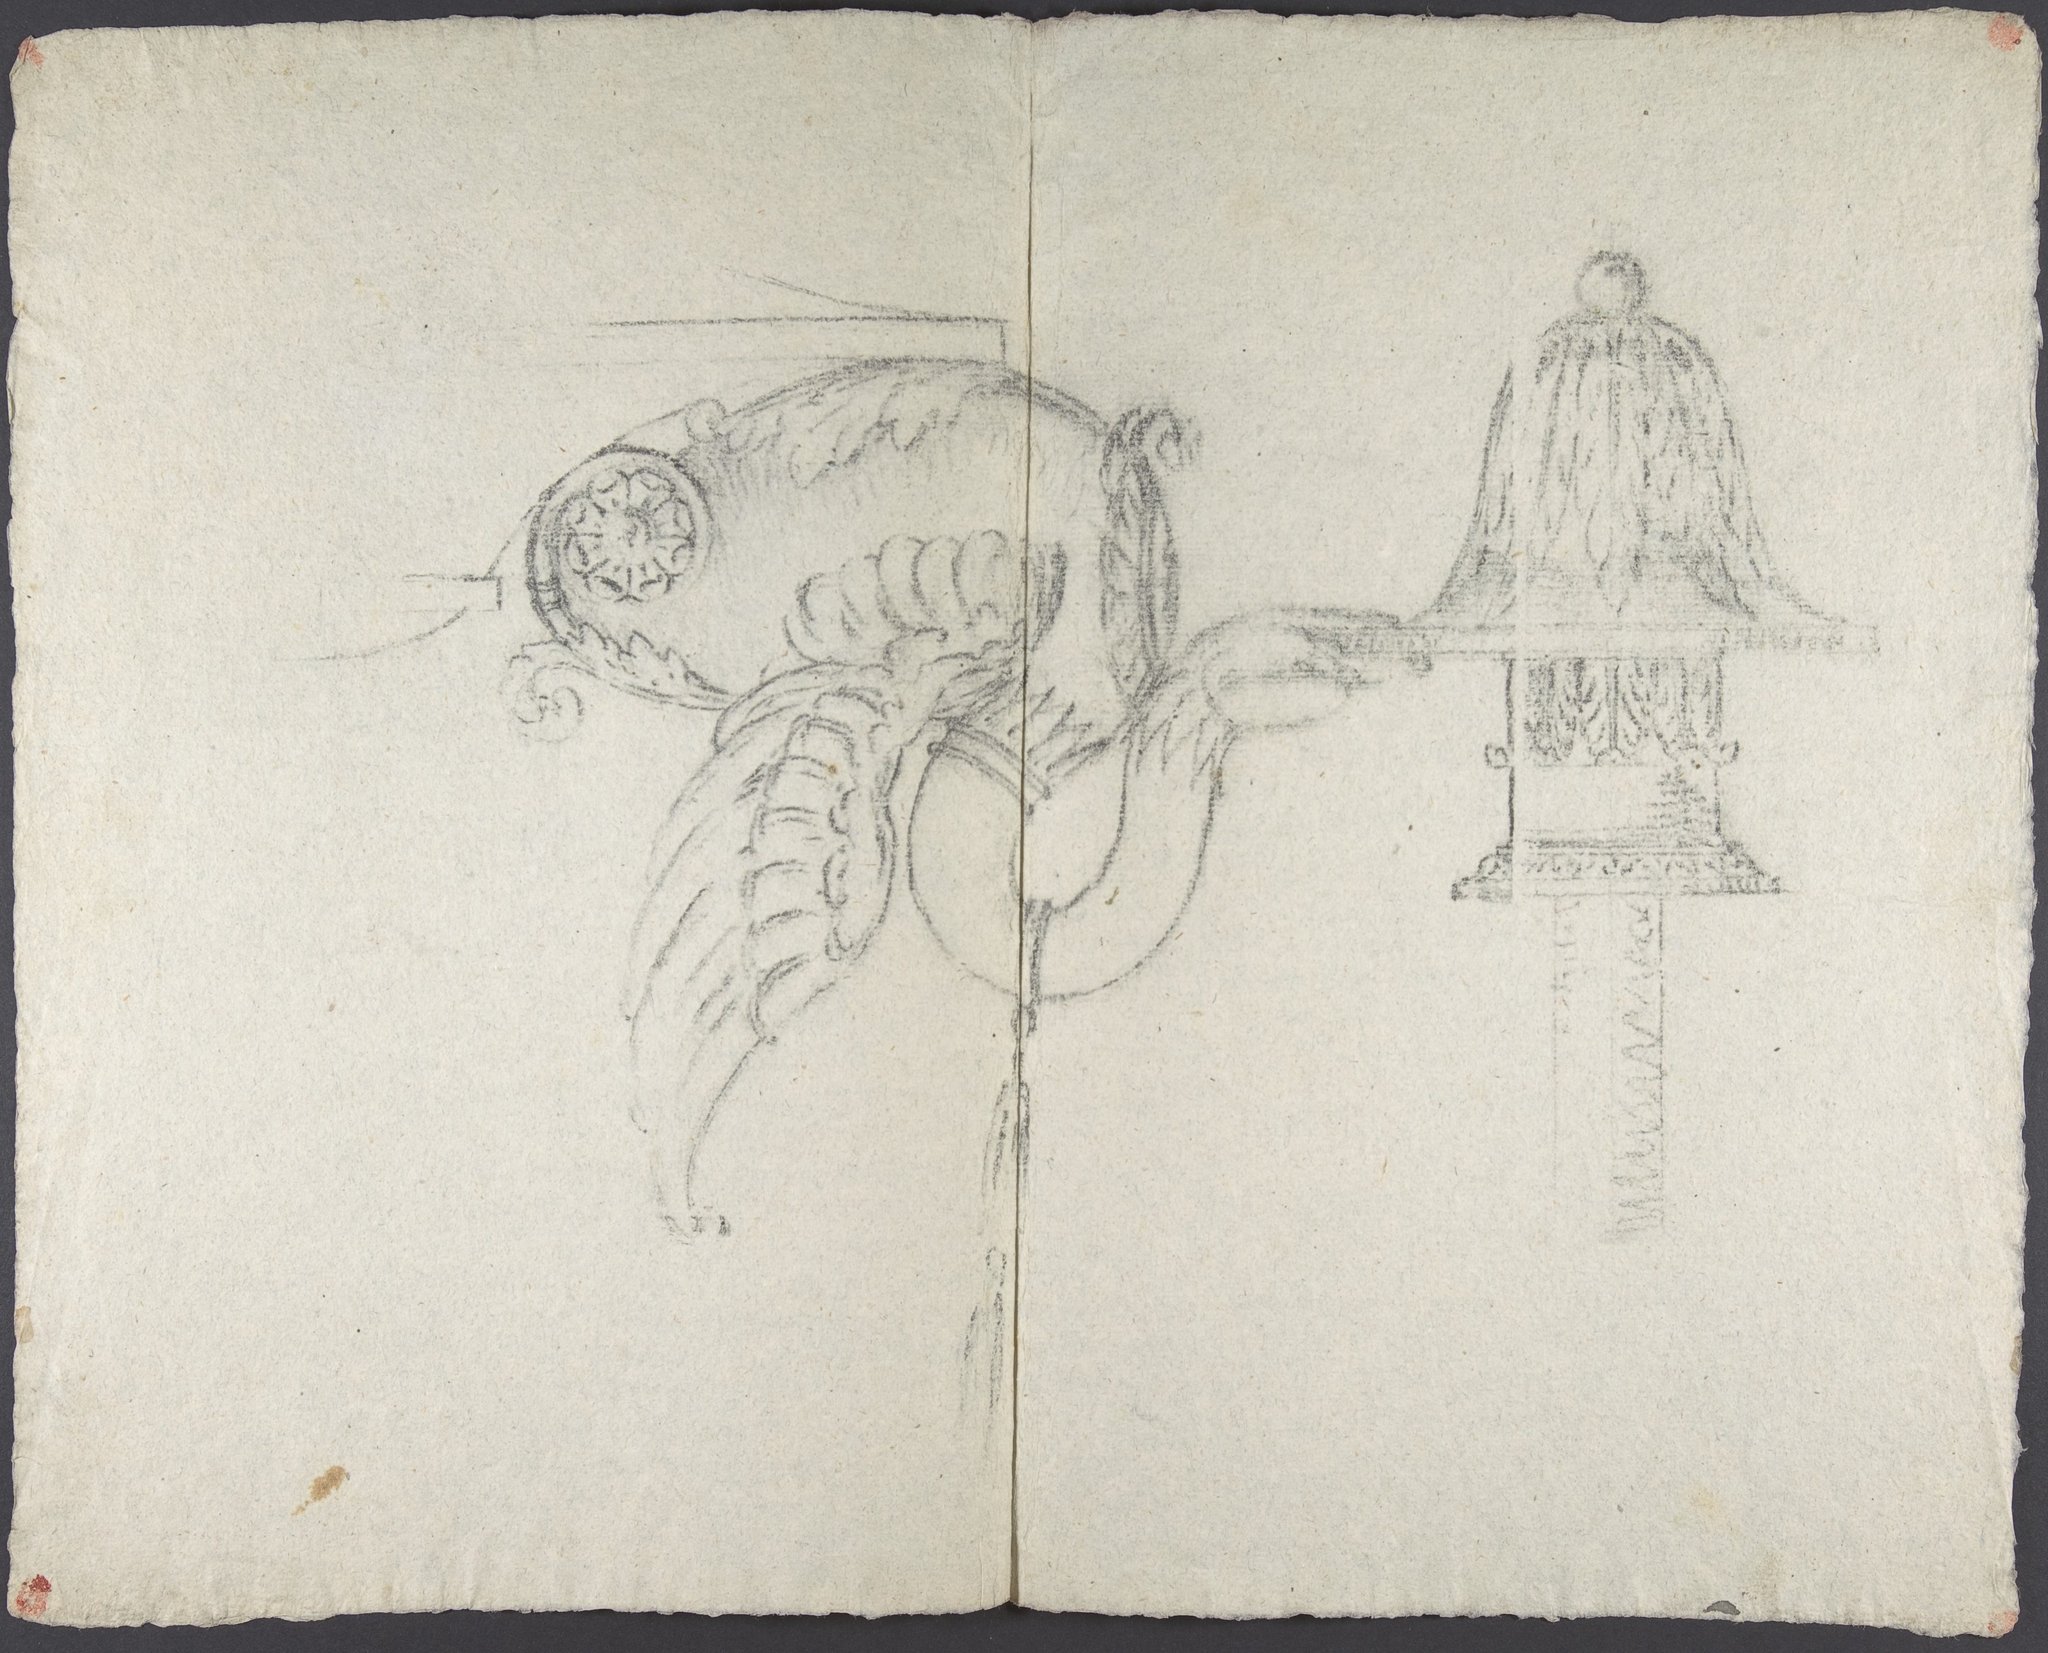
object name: drawing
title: Design for a chandelier: detail of a swan holding a candlestick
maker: anonymous, german, 19th century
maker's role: artist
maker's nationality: german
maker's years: 1800-1899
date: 1801-1833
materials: chalk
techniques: printmaking, drawing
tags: swans